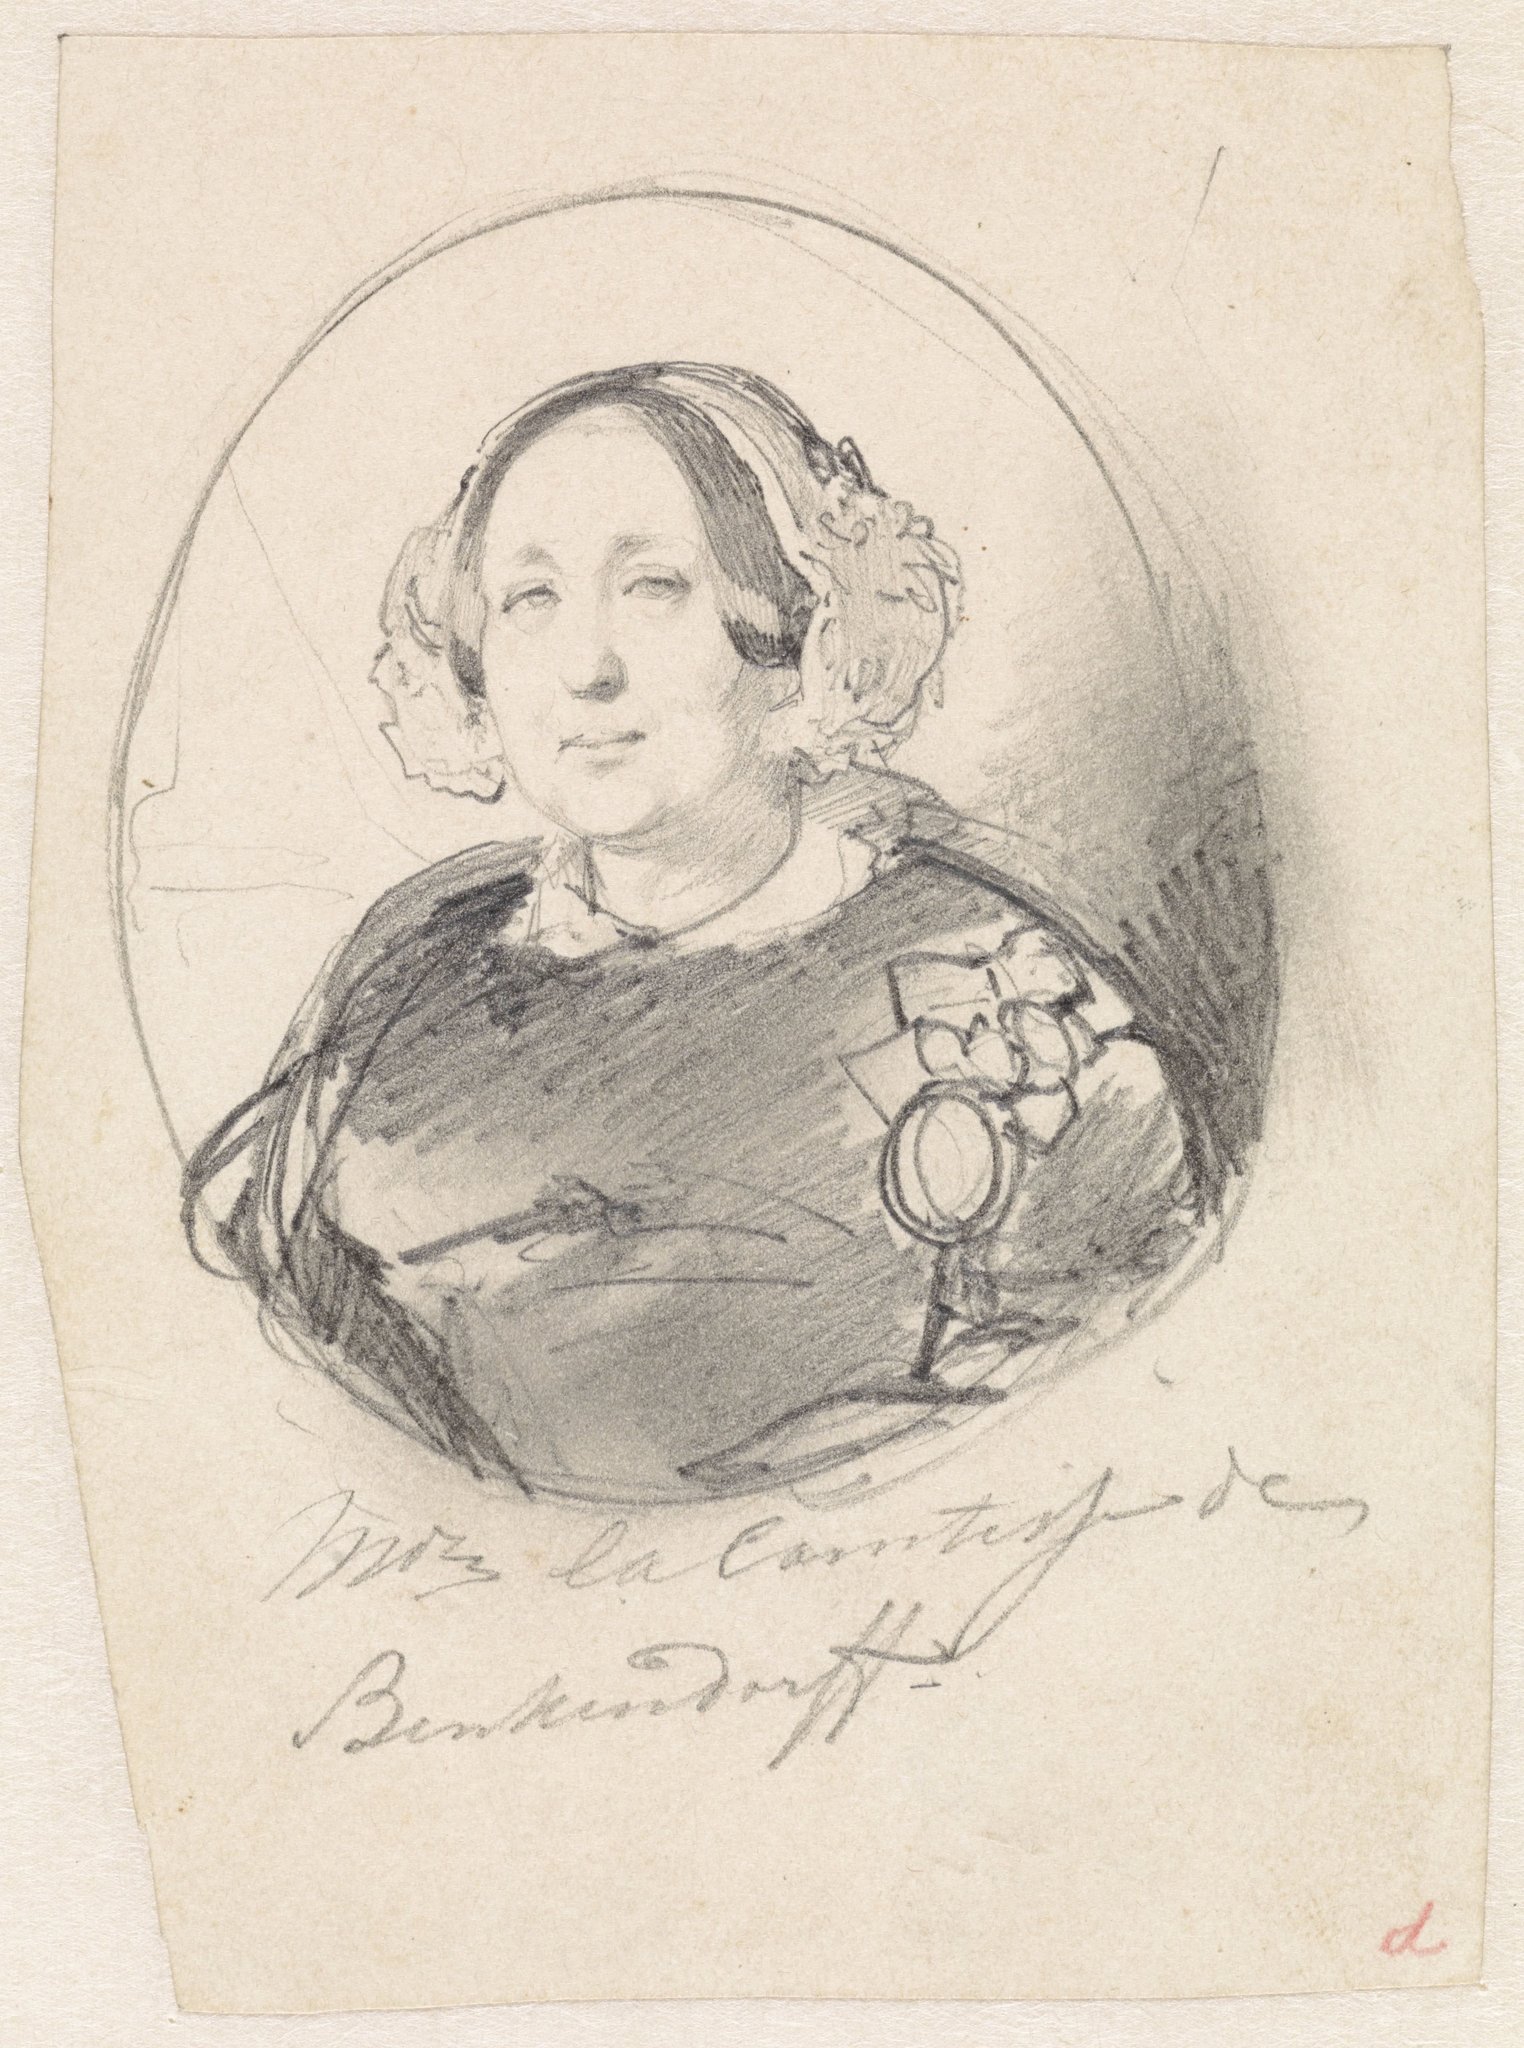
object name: drawing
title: Portret van de gravin van Benkendorff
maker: johan hendrik koelman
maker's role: draughtsman, print maker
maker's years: 1820-1887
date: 1830-1887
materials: paper, pencil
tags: historical persons